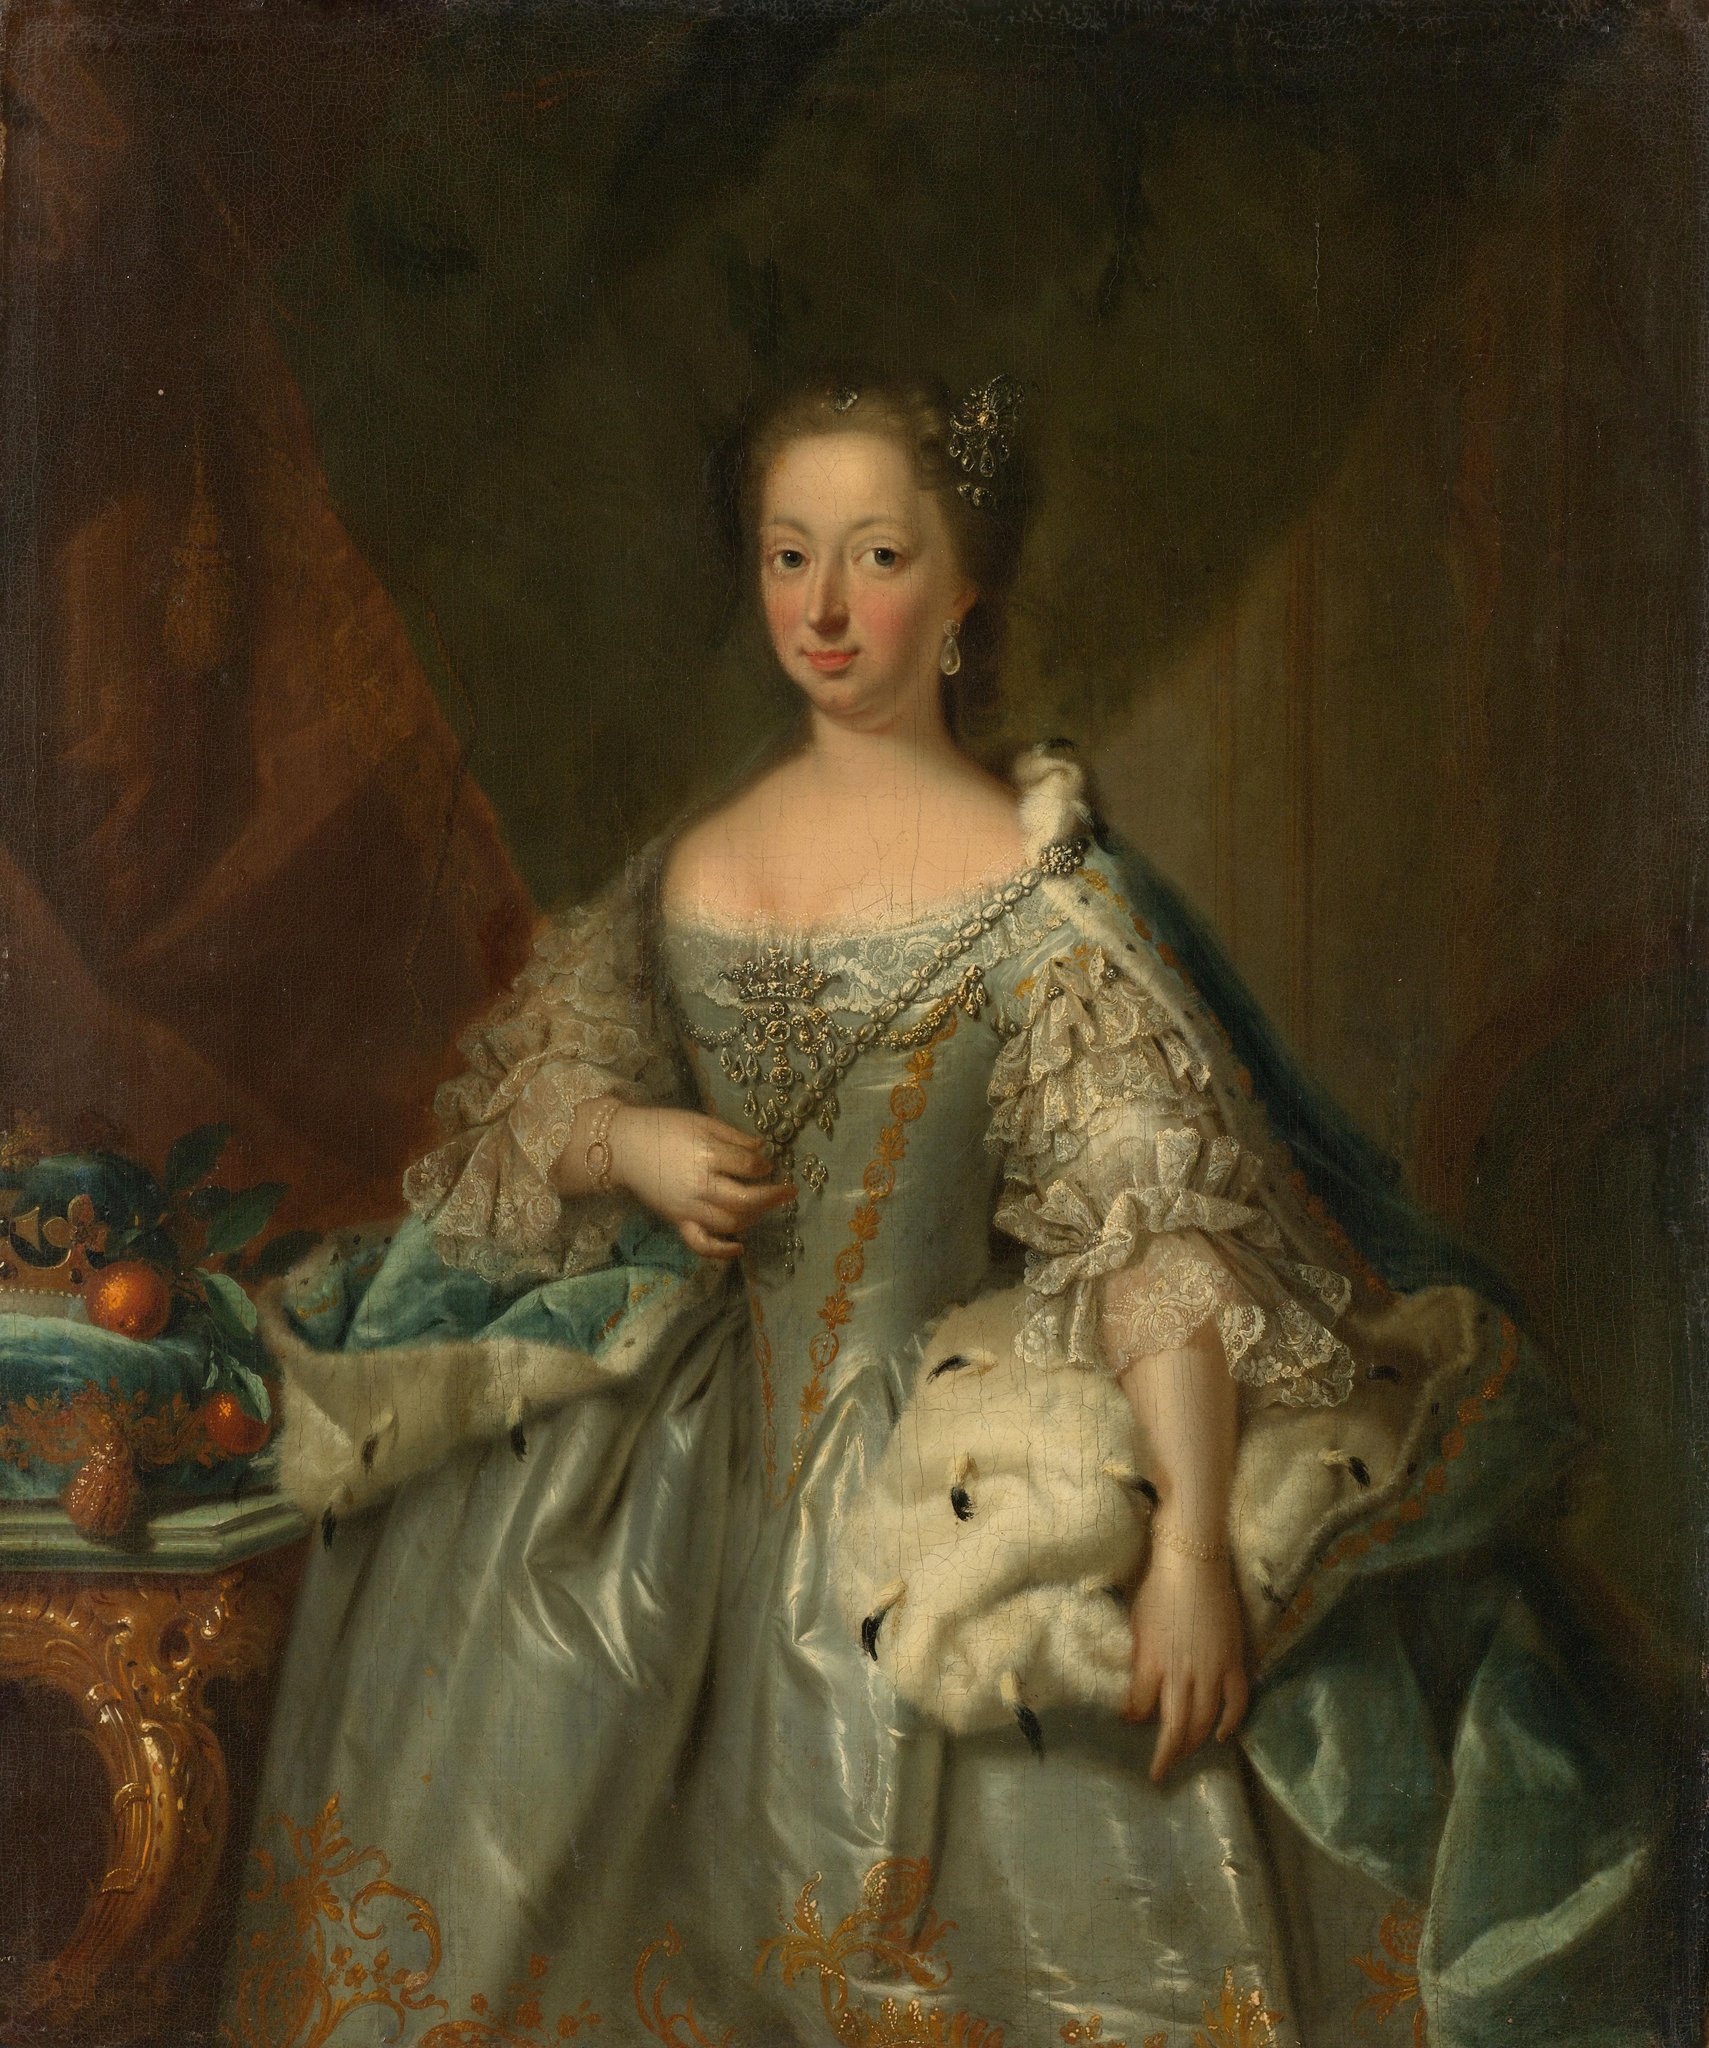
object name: painting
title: Portrait of Anne of Hanover, Princess Royal and Princess of Orange, Consort of Prince William IV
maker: johann valentin tischbein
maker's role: painter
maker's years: 1715-1768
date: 1753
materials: canvas, oil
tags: willem iv (prins van oranje-nassau), the hague, anna van hannover, historical persons - bb - woman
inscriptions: signature and date: ‘J. Tischbein 1753’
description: Anna of Hannover, attributed to J.V. Tischbein, 1753. Princess Anna was the eldest daughter of George II of England. In 1734 she married William IV. After the death of the stadholder in 1751, Anna ruled as regent in the place of her infant son, the later stadholder, William V. Anna is depicted two years after her husband's death. About her wrist is a bracelet, perhaps with a miniature portrait of William. Beside the oranges is the royal crown of England.